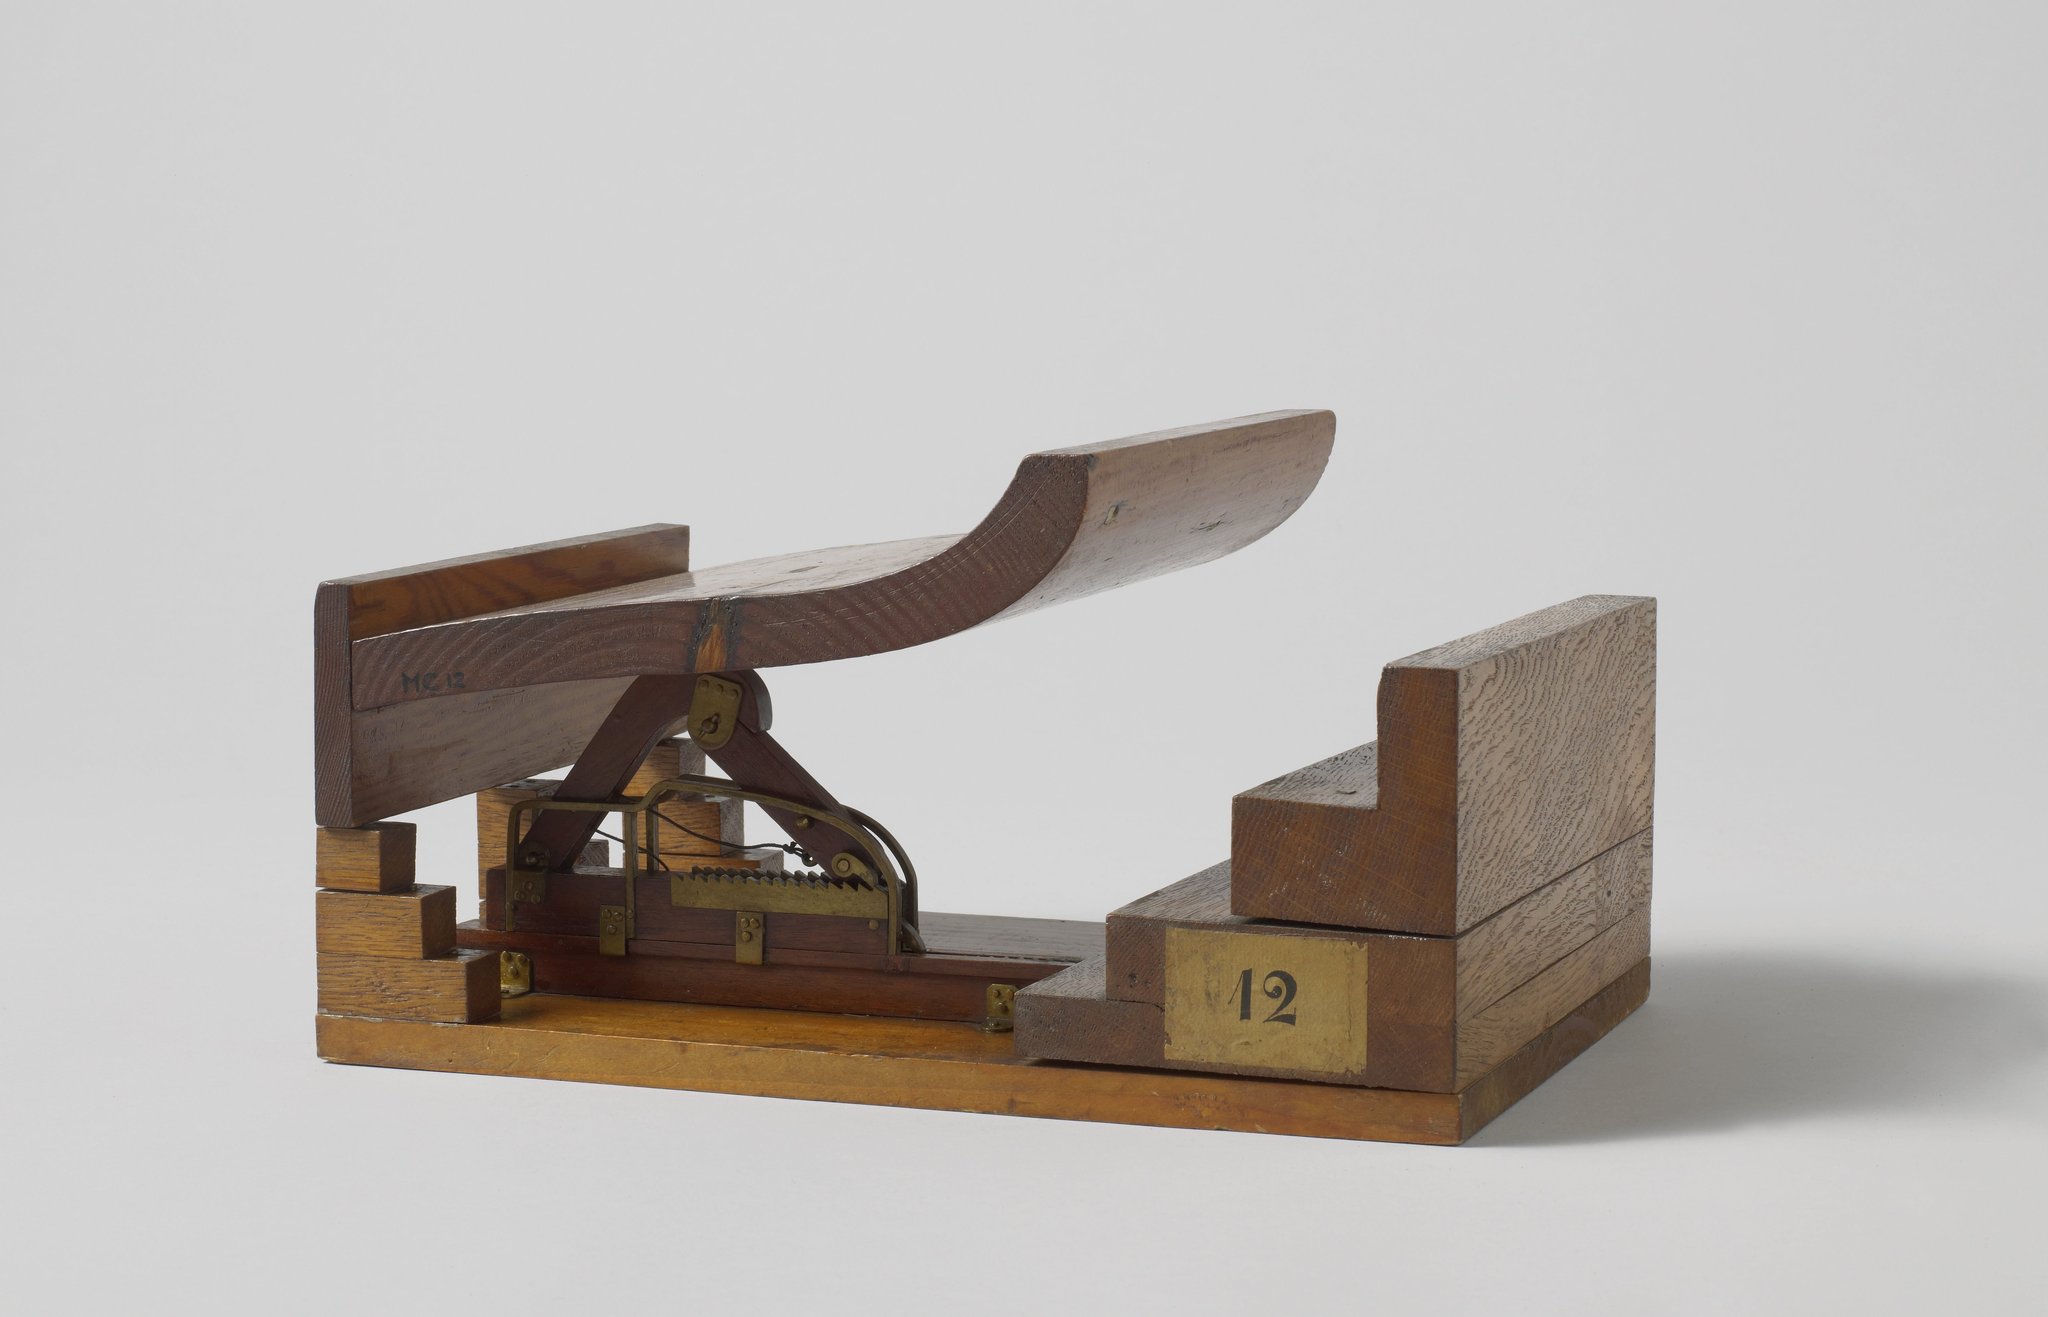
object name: demonstration model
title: Model of a Support in a Dry Dock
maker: Anonymous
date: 1849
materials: brass, wood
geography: united states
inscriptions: label, on the dock: ‘12’ former inventory label, inscription, on the ship’s side, in pencil: ‘Hotel [...] / no. 19.’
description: Schematisch model van een deel van een droogdok, met deel van een scheepswand op blokken ondersteund door een samengestelde bok: met een heugel en pal kan de bok in verschillende standen gezet worden, zich aanpassend aan de helling en hoogte van het scheepsvlak.